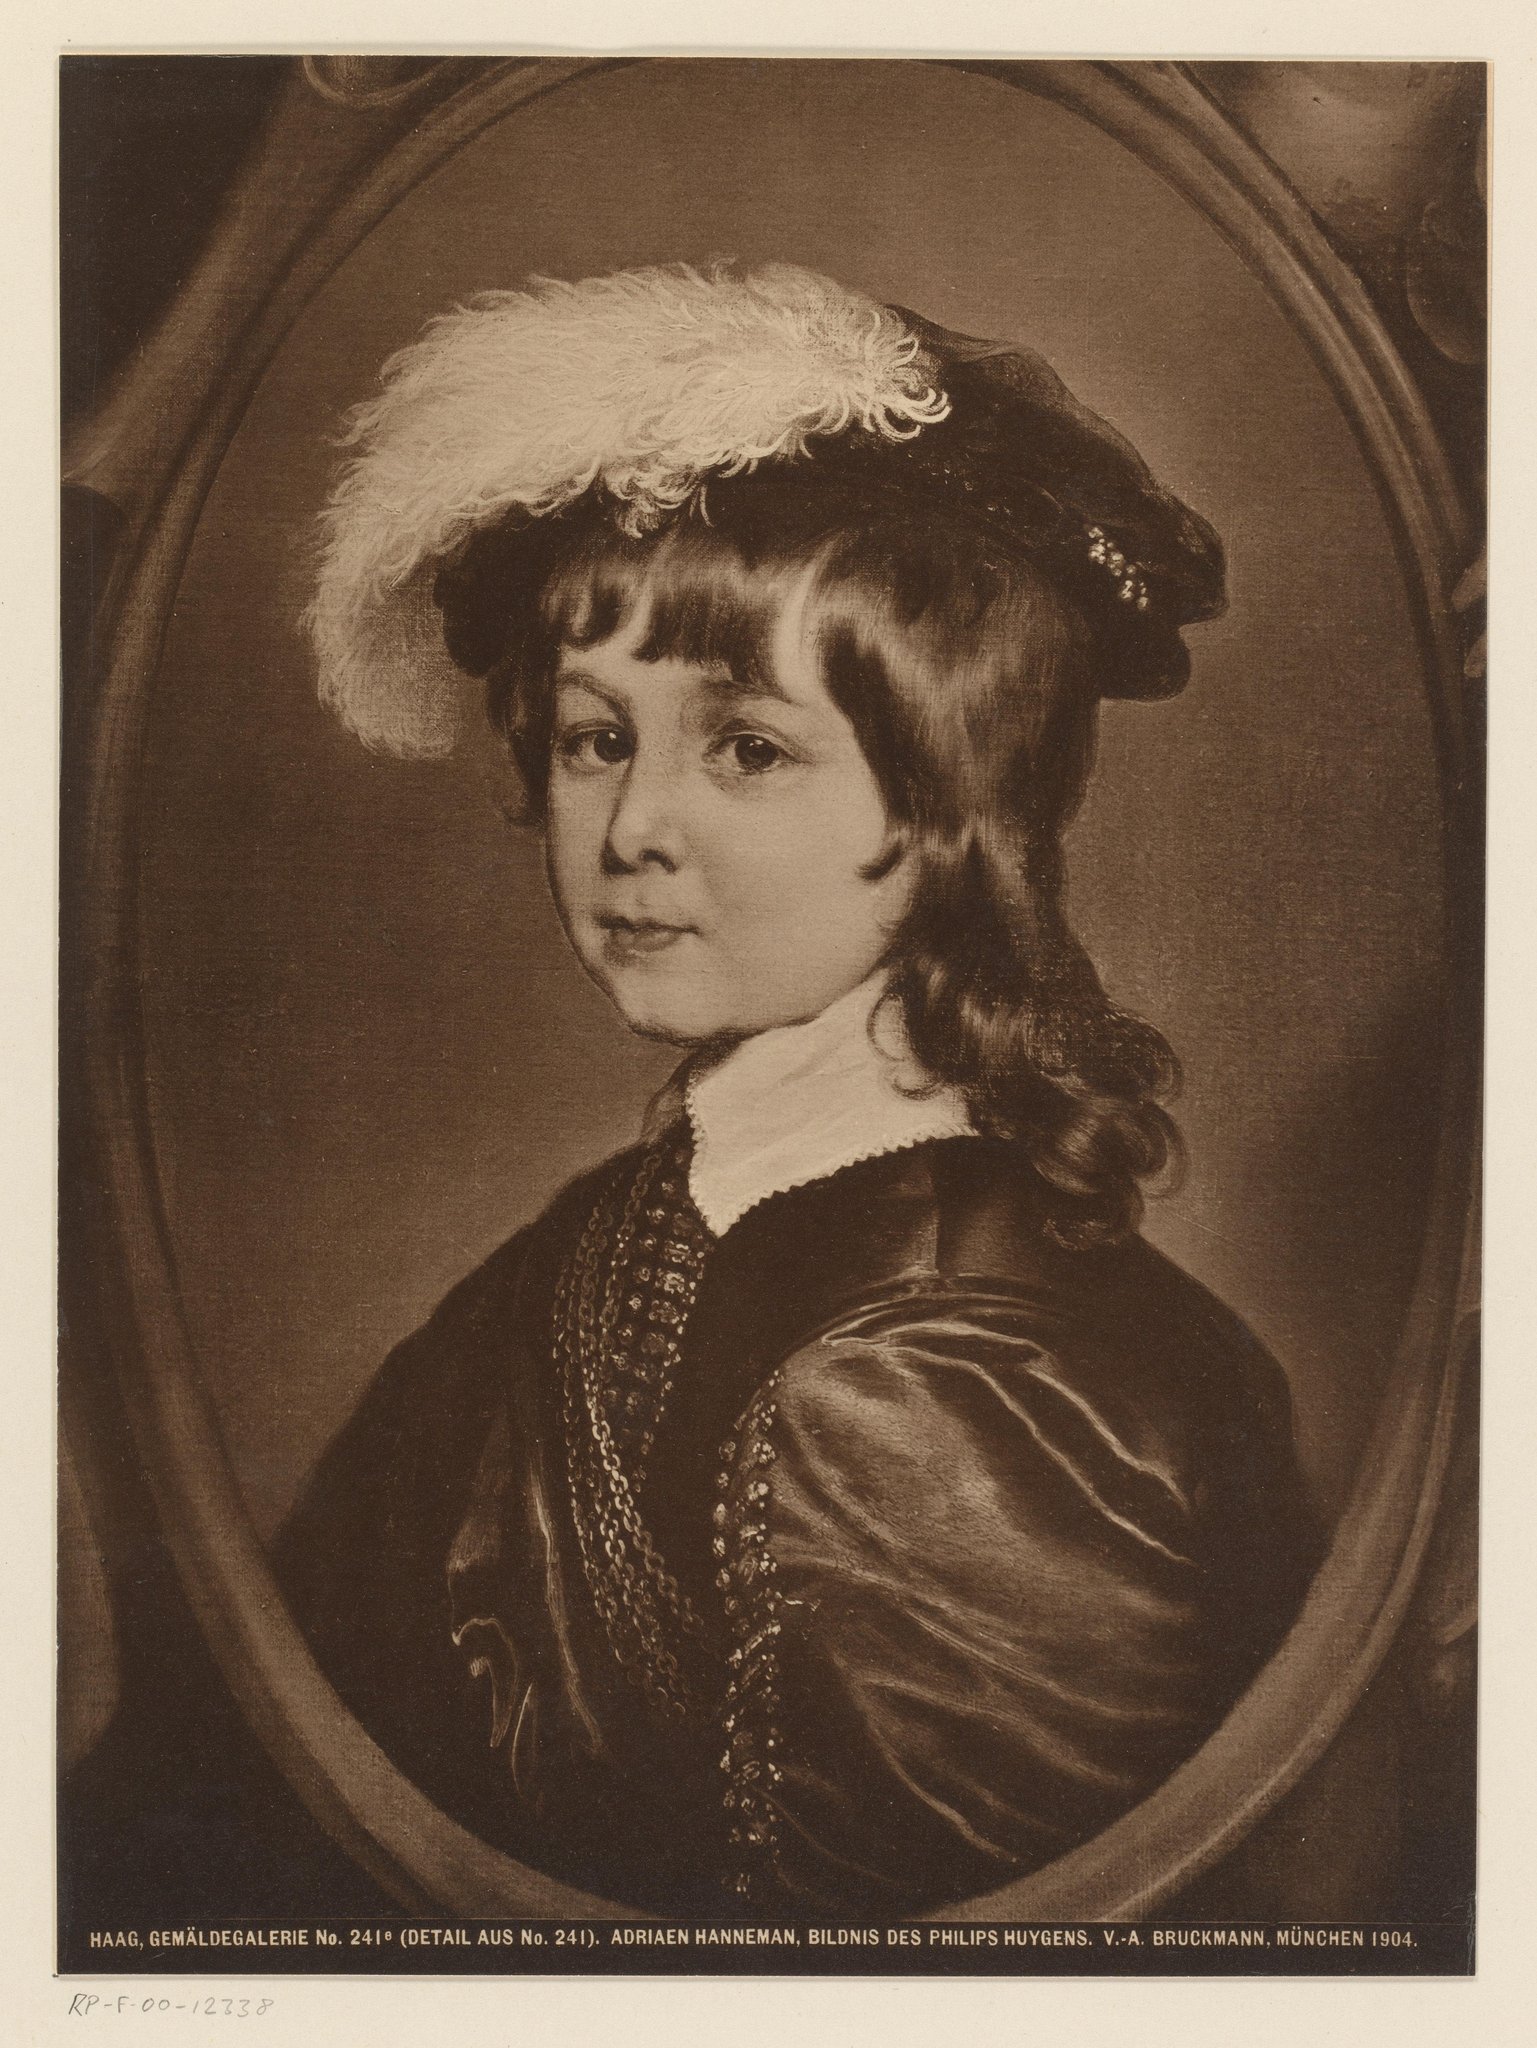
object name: reproduction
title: Fotoreproductie van een geschilderd portret van Philips Huygens, door Adriaen Hanneman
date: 1904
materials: paper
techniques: photograph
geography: munich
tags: philips huygens, historical persons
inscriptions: inscription: ‘HAAG, GEMÄLDEGALERIE No. 241e (DETAIL AUS No. 241).’